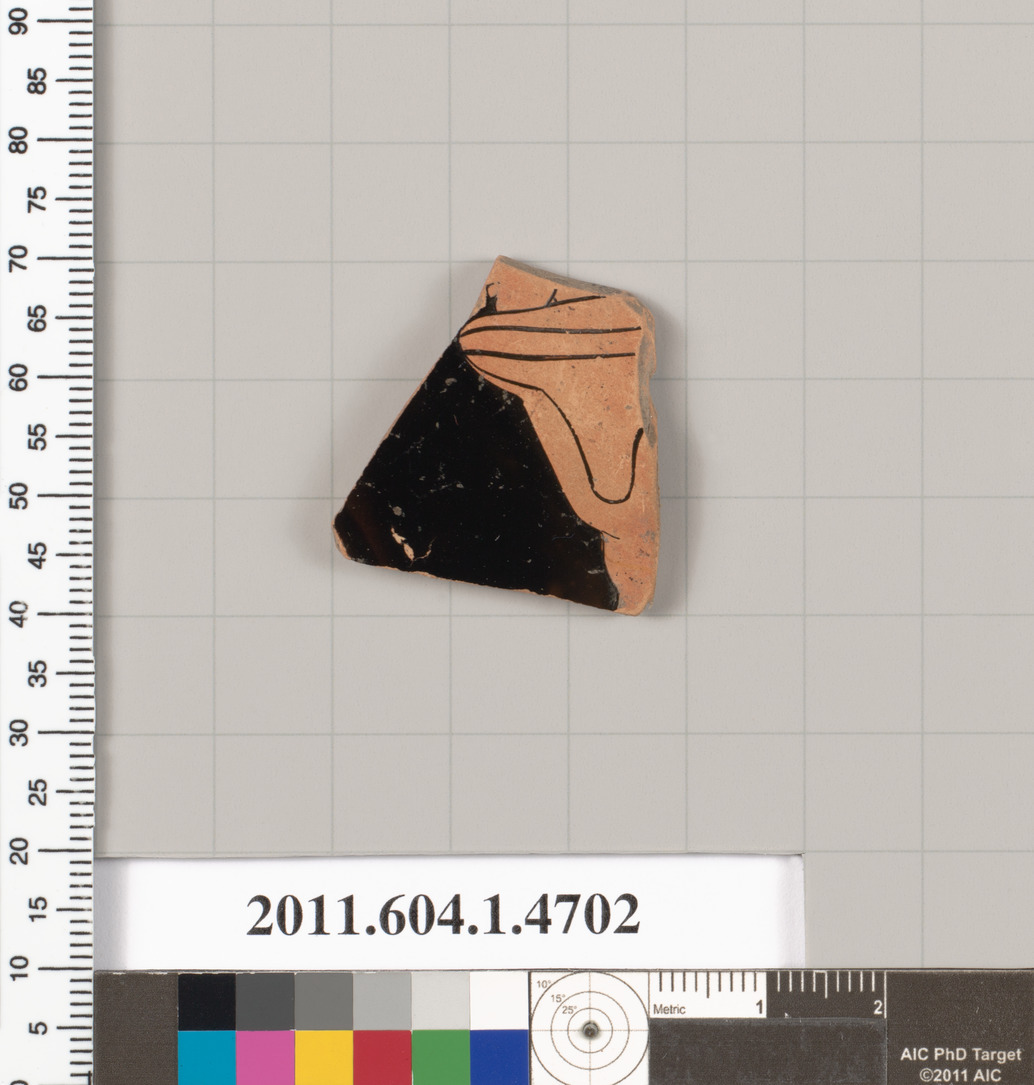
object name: kylix fragment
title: Terracotta fragment of a kylix (drinking cup)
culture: greek, attic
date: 490-470 BCE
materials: terracotta